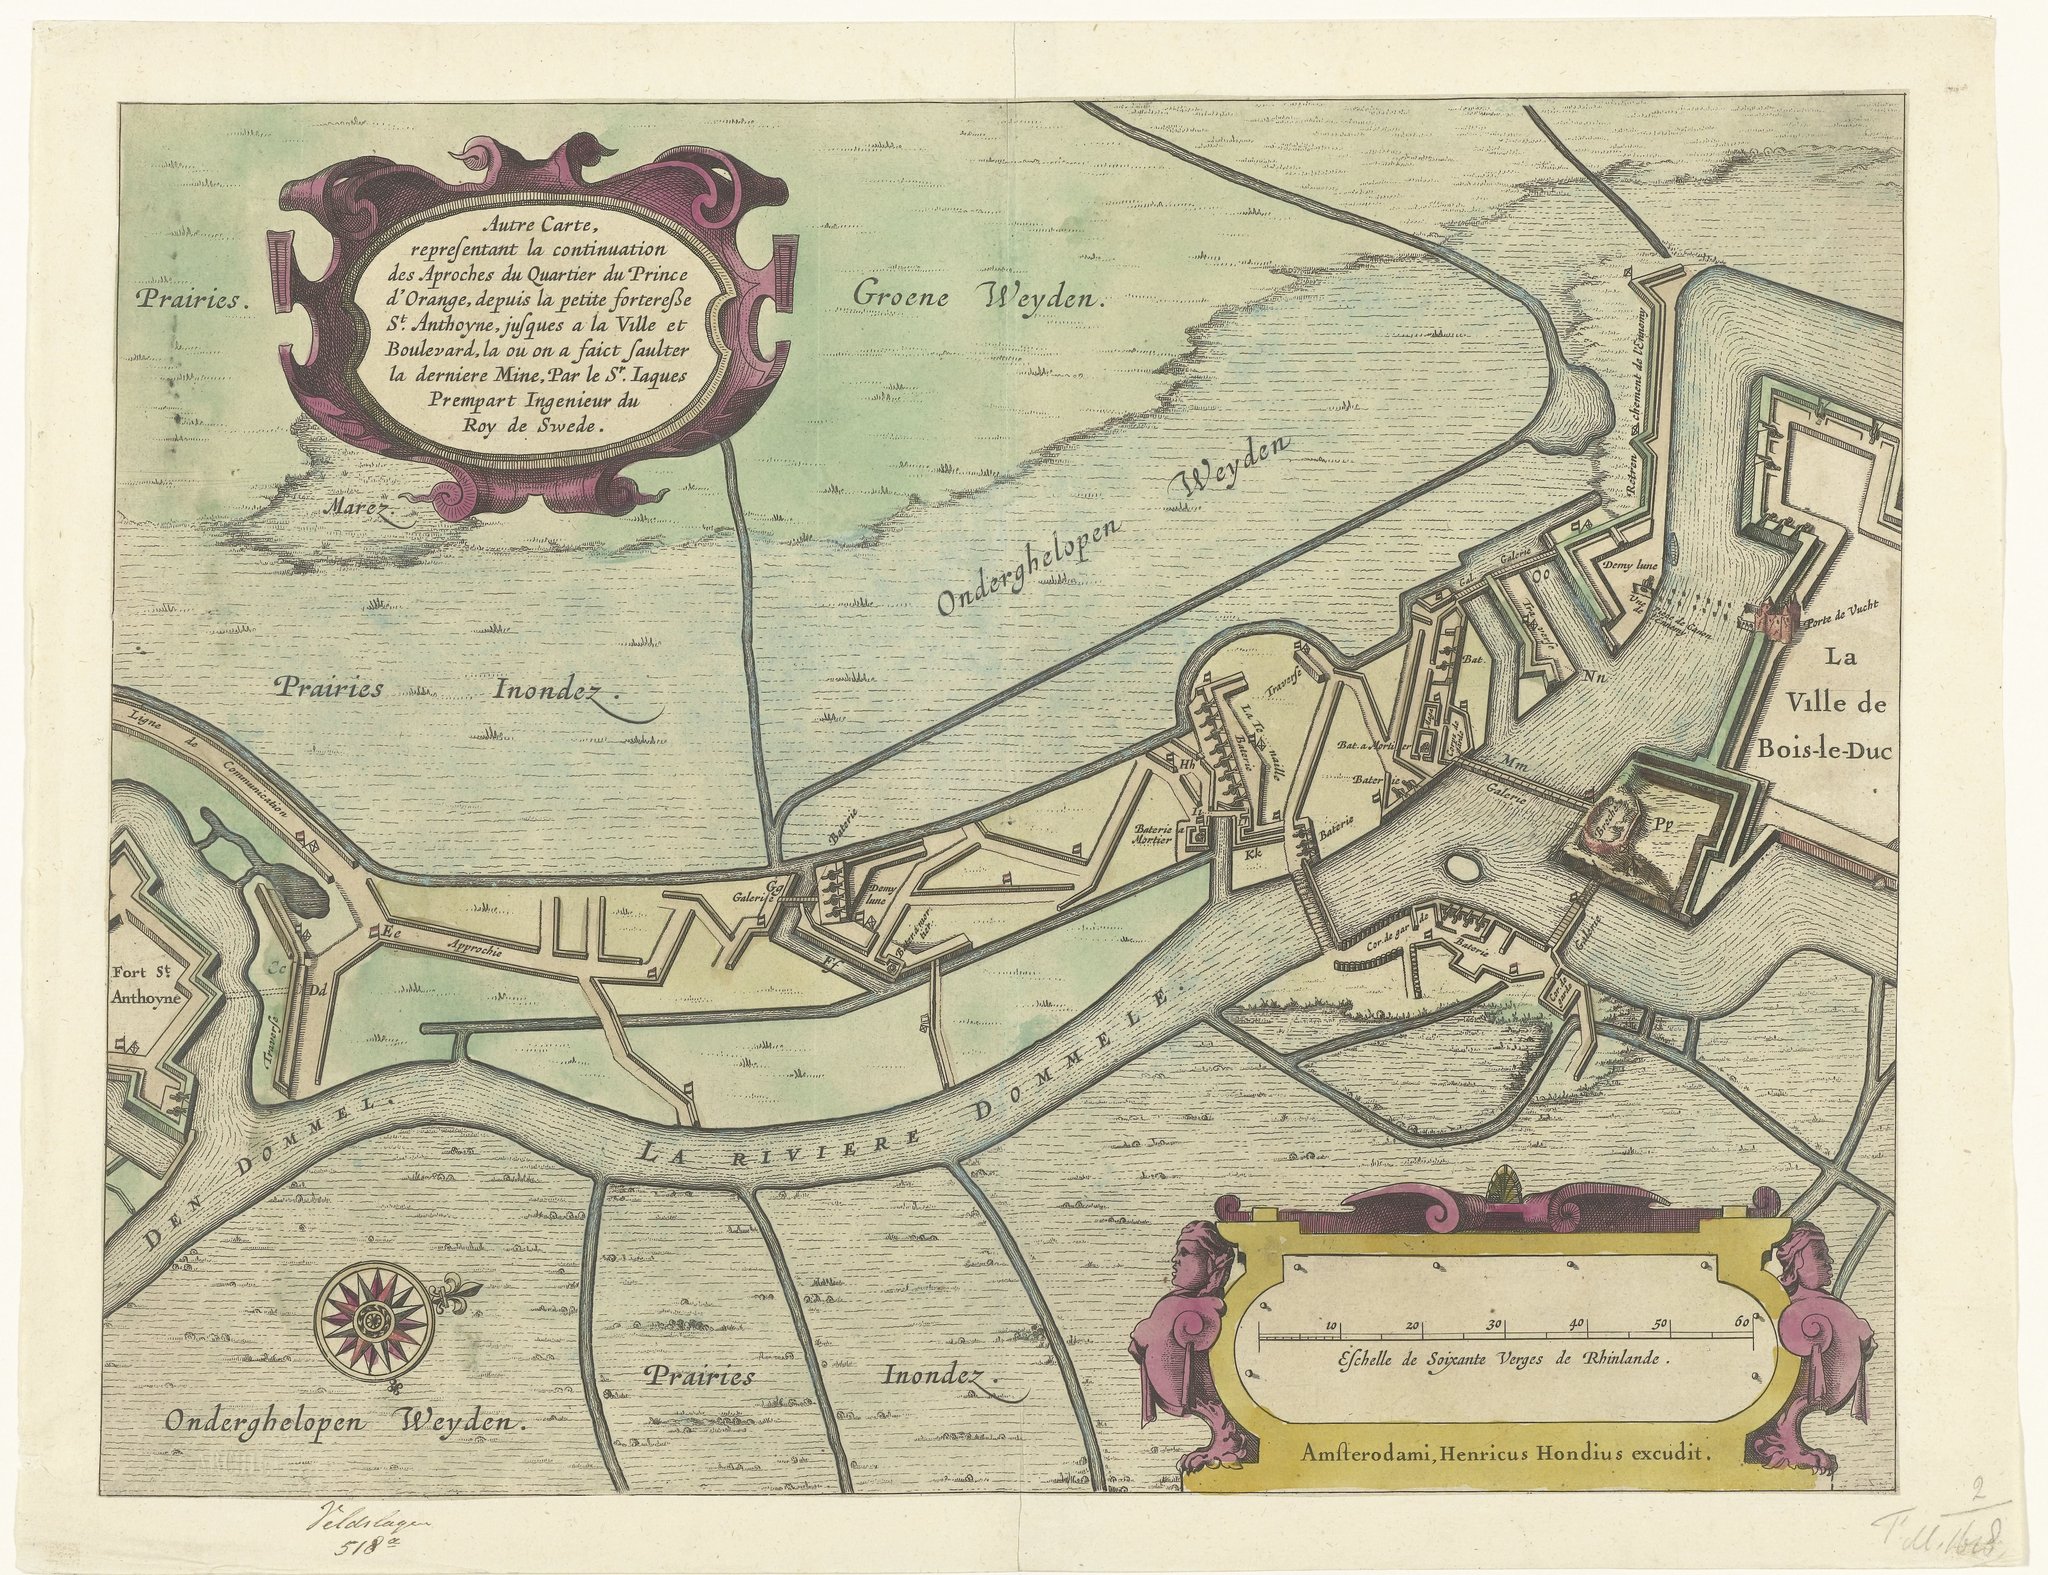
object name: map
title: Zeven deelkaarten betreffende het beleg van Den Bosch in 1629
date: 1629-1630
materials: paper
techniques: etching, hand coloring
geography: amsterdam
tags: delft, the hague, frederick henry (prince of orange), maps of separate countries or regions, fortifications, military engineering, den bosch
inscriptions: collector's mark, inscription: ‘Veldslagen 518a’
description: Loopgraven van het Staatse leger vanaf het fort Sint-Anthonie langs de Dommel tot aan de stad. Onderdeel van het beleg van Den Bosch door het Staatse leger onder Frederik Hendrik, van 1 mei tot 17 september 1629. Opschriften in de voorstelling in het Frans en Nederlands. Behoort waarschijnlijk bij de grote kaart van het beleg.